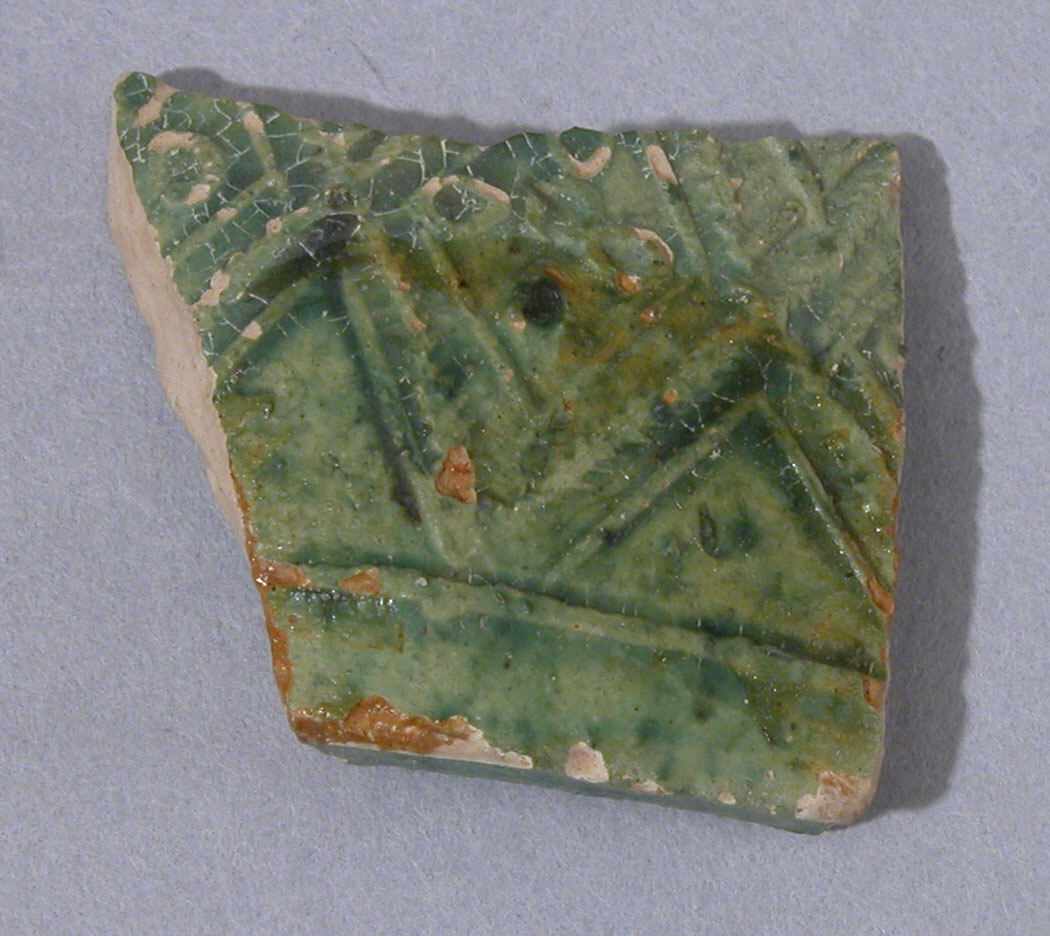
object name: fragment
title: Ceramic Fragment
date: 801-900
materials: earthenware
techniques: glazing, molding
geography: saudi arabia